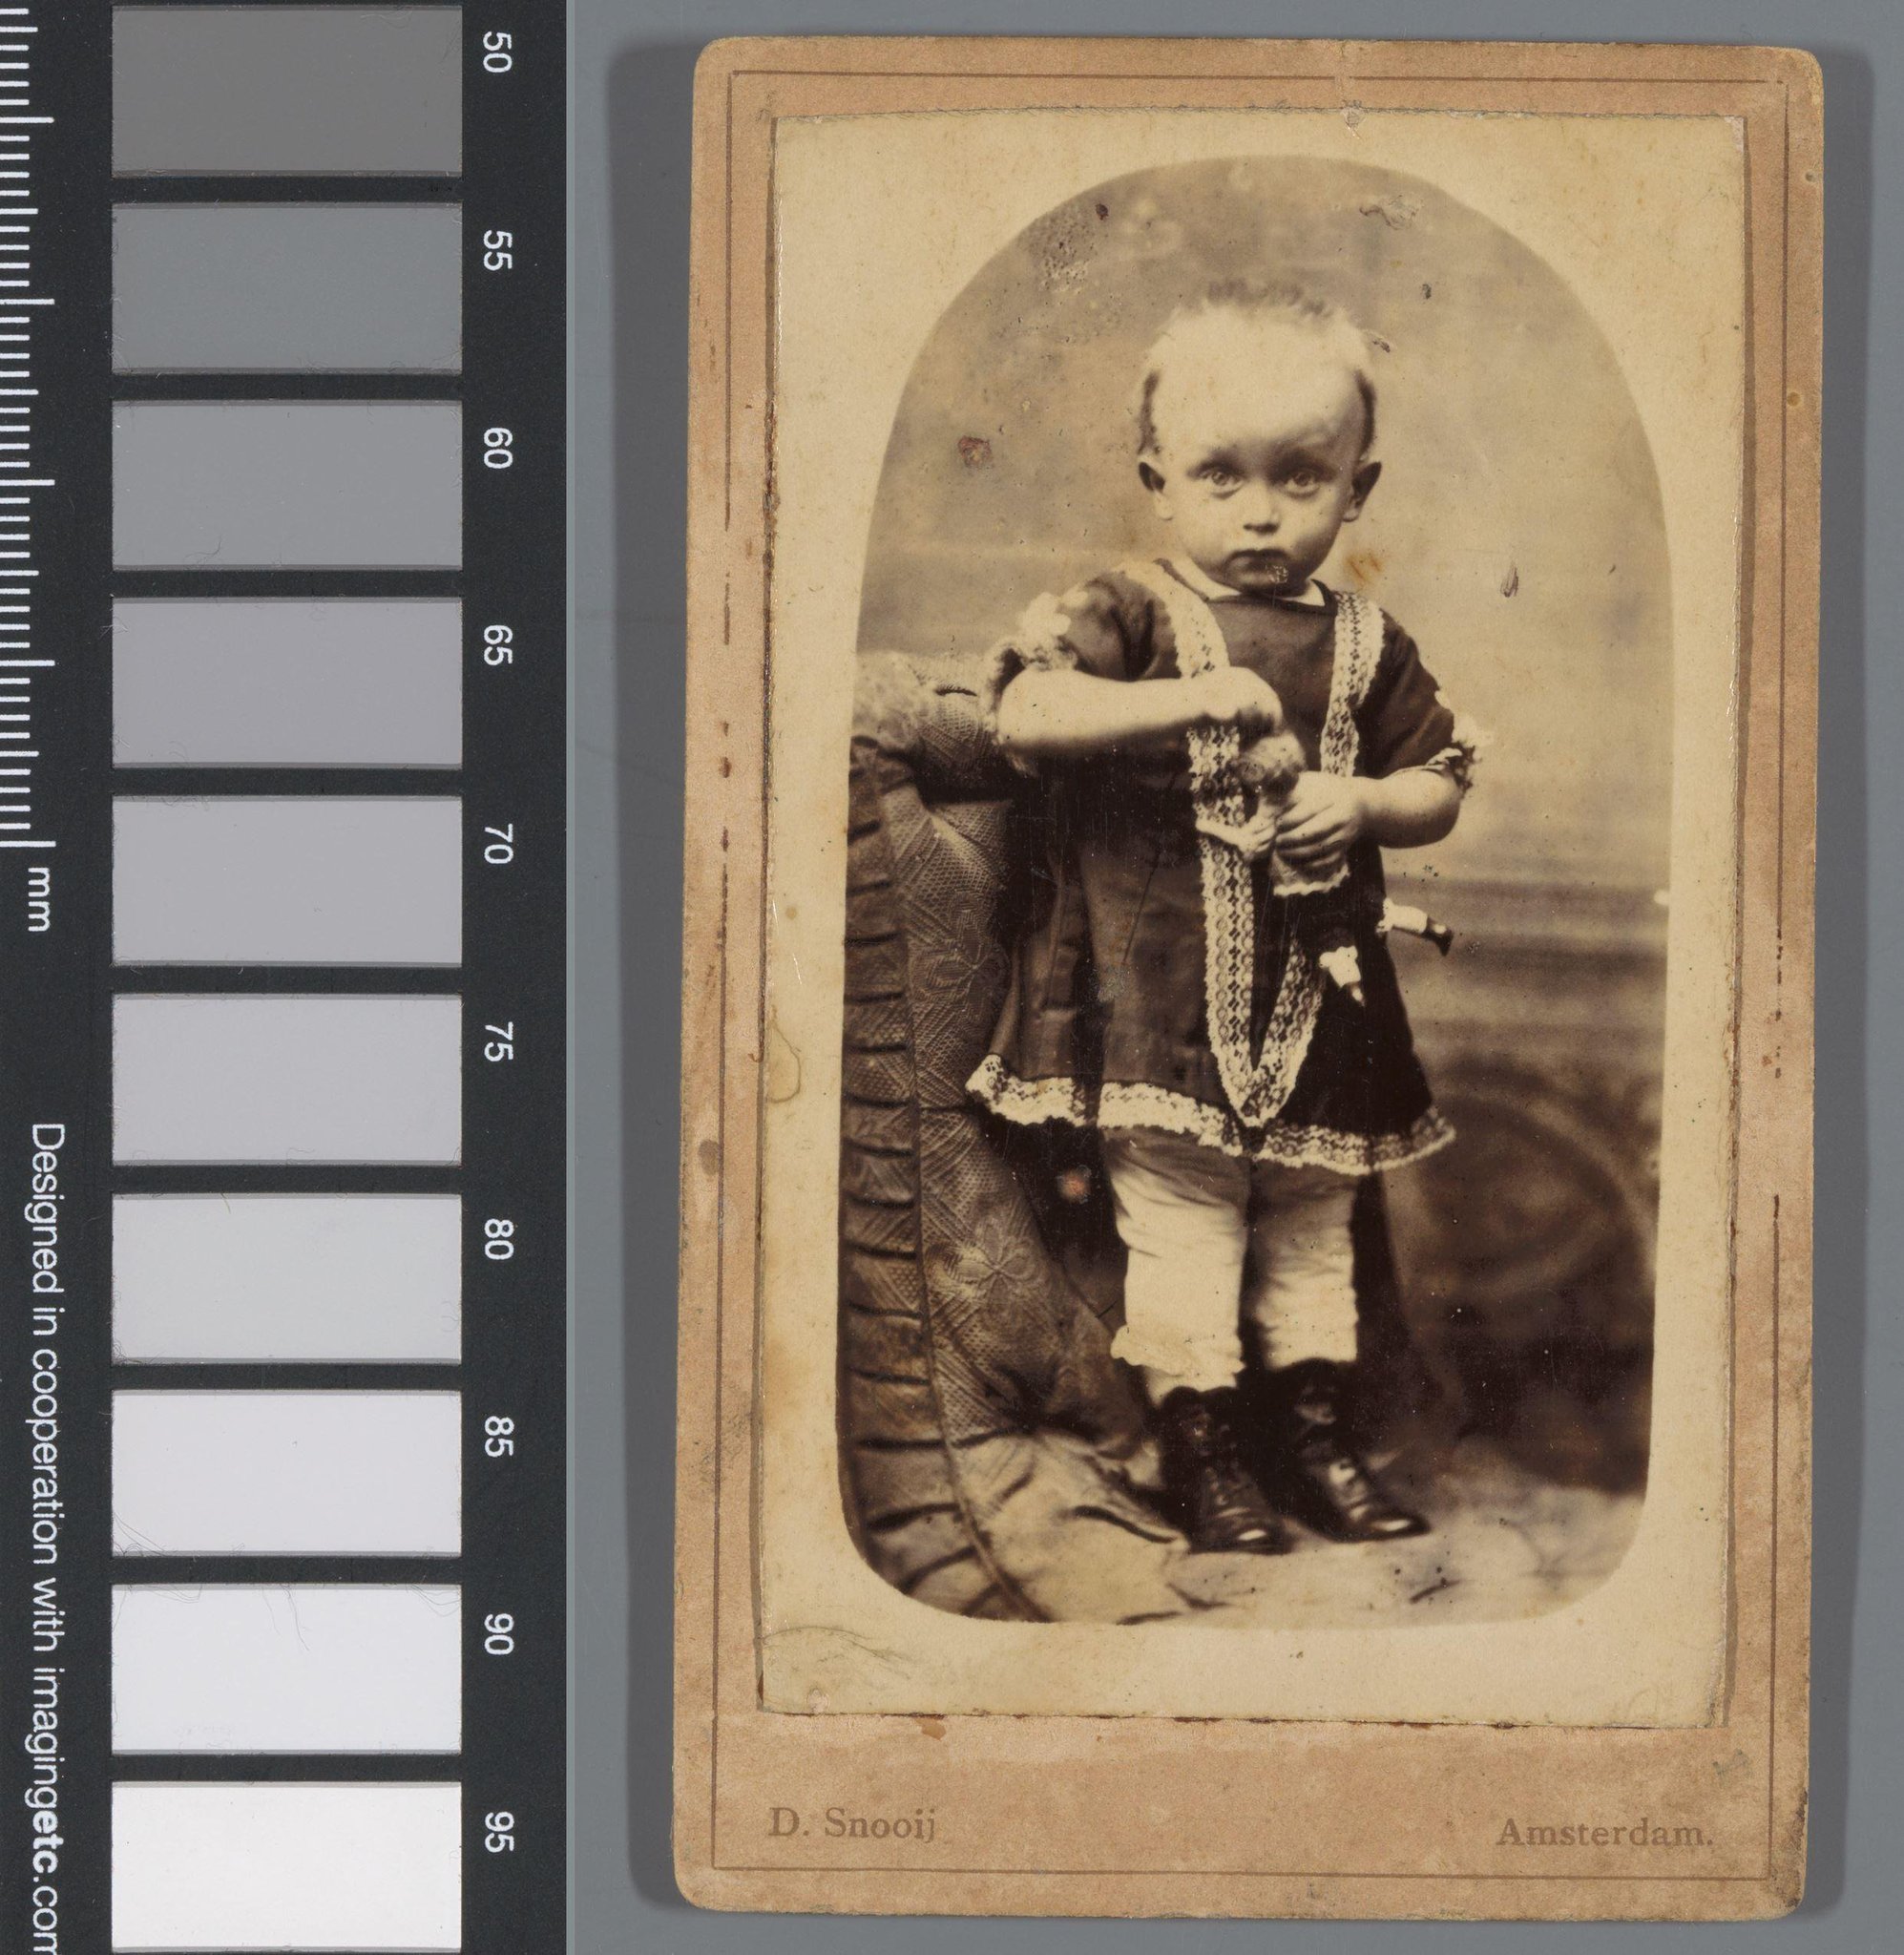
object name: photograph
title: Portret van een onbekend kind met pop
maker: david snooij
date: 1878-1889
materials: cardboard, paper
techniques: albumen print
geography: amsterdam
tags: child, historical persons, (playing with) dolls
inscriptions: inscription: ‘Photographisch/ ATELIER/ van/ D. Snooij/ Rozengracht No. 11./ AMSTERDAM.’